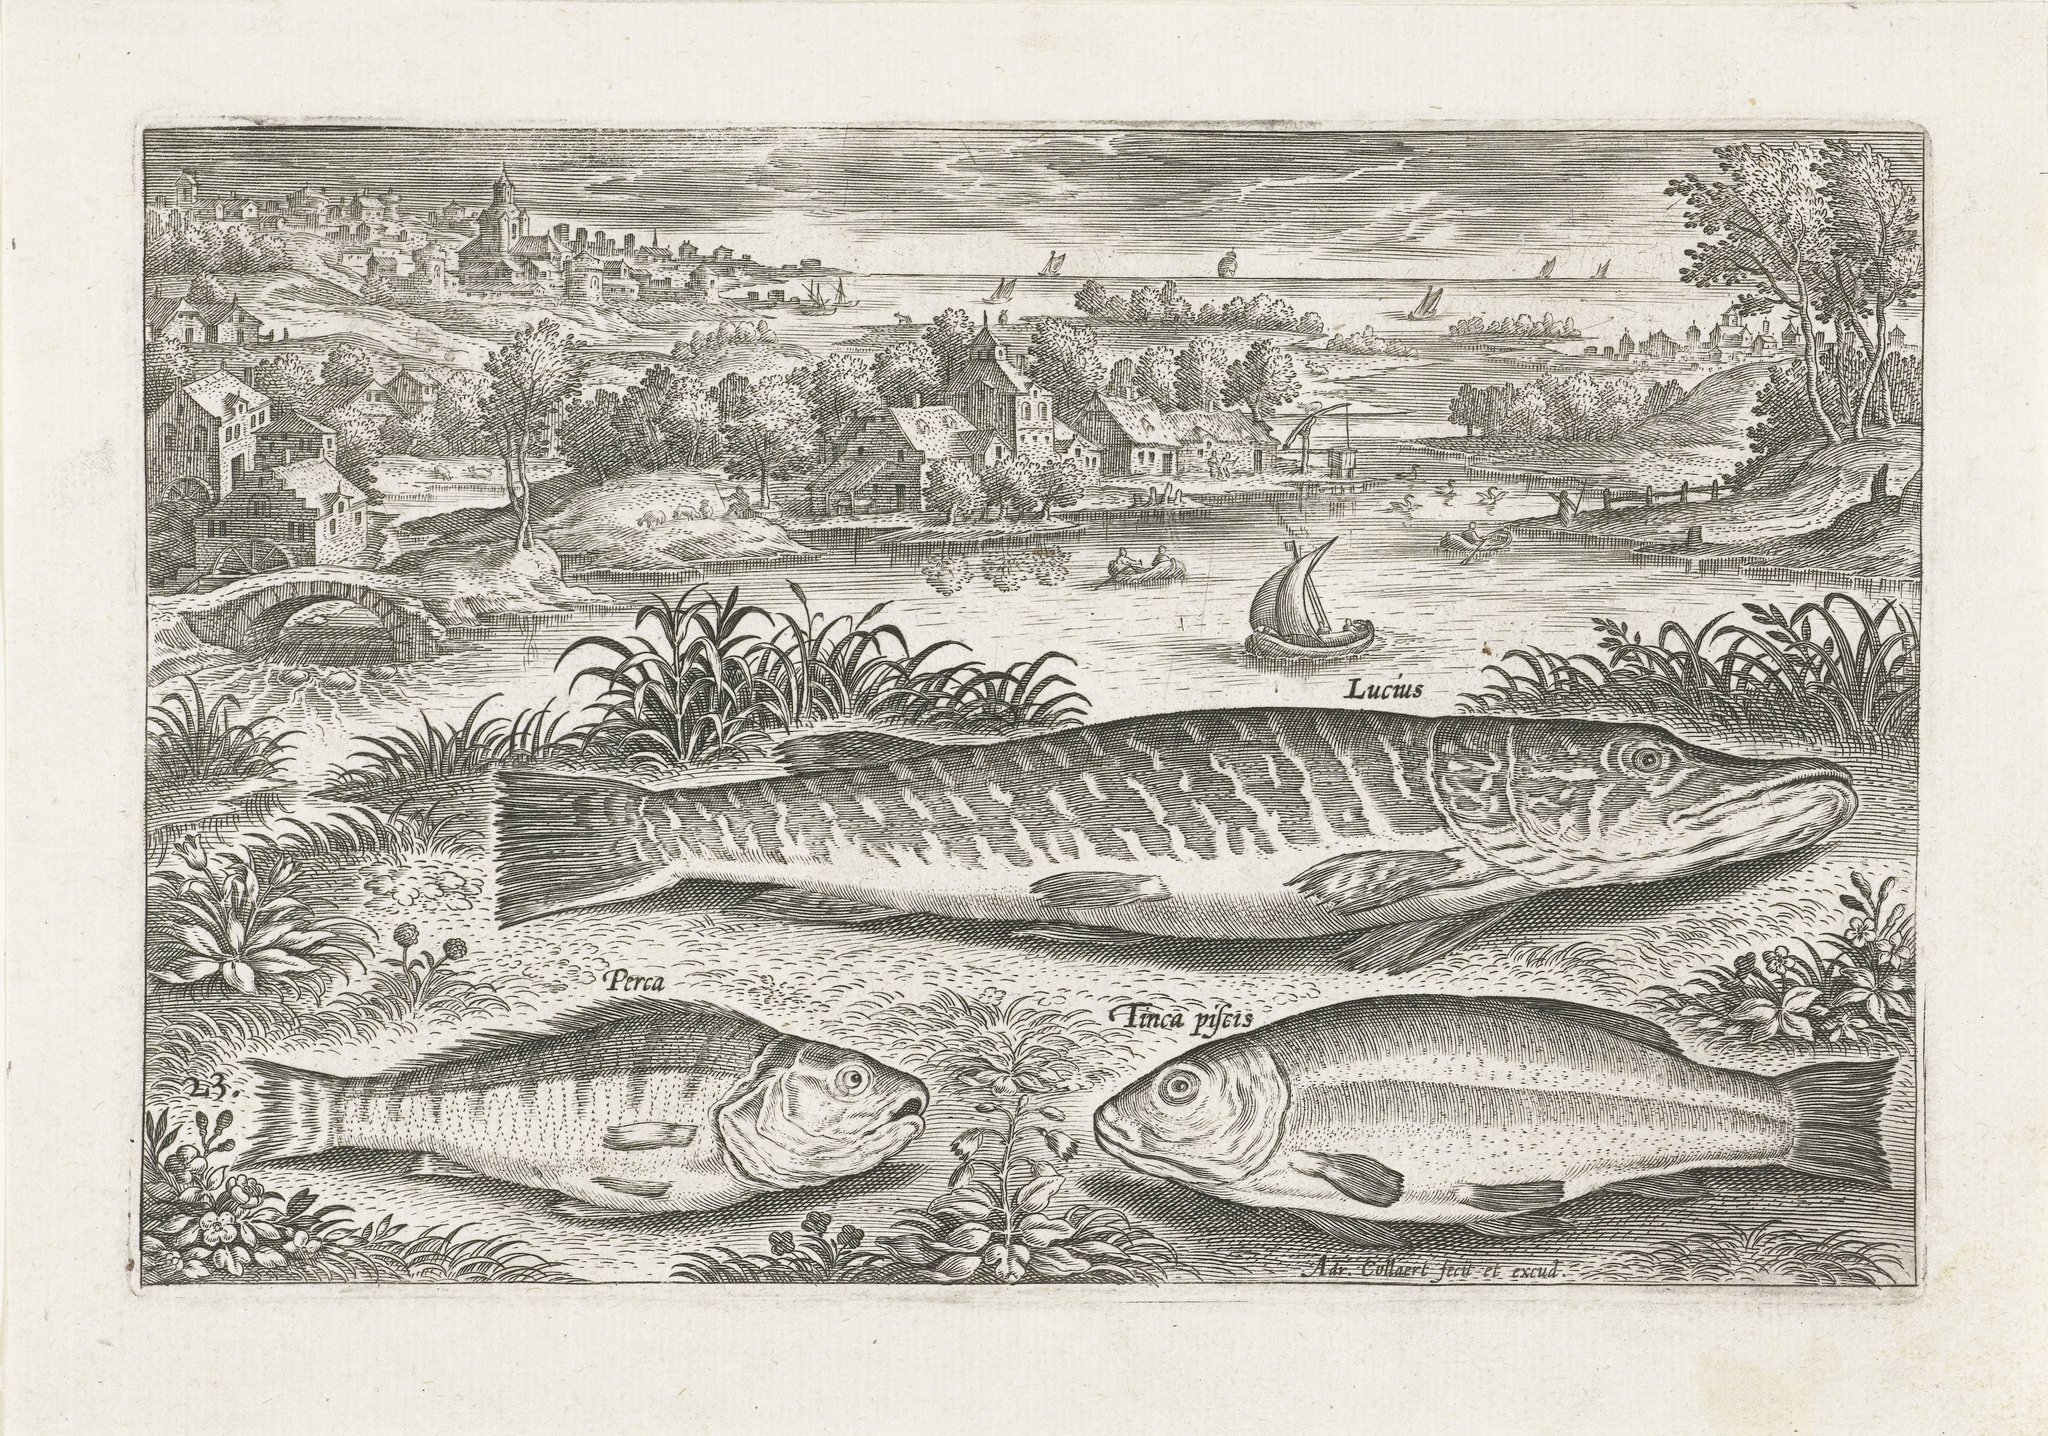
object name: print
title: Vissen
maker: adriaen collaert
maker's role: draughtsman, print maker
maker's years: 1560-1618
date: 1598-1618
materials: paper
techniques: engraving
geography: antwerp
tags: river, bony fishes: pike, bony fishes: tench, bony fishes: perch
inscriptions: collector's mark: Lugt 2228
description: Een snoek, een baars en een zeelt liggen samen op de oever van een rivier. Op de achtergrond de rivier. De prent maakt deel uit van een serie met vissen als onderwerp.